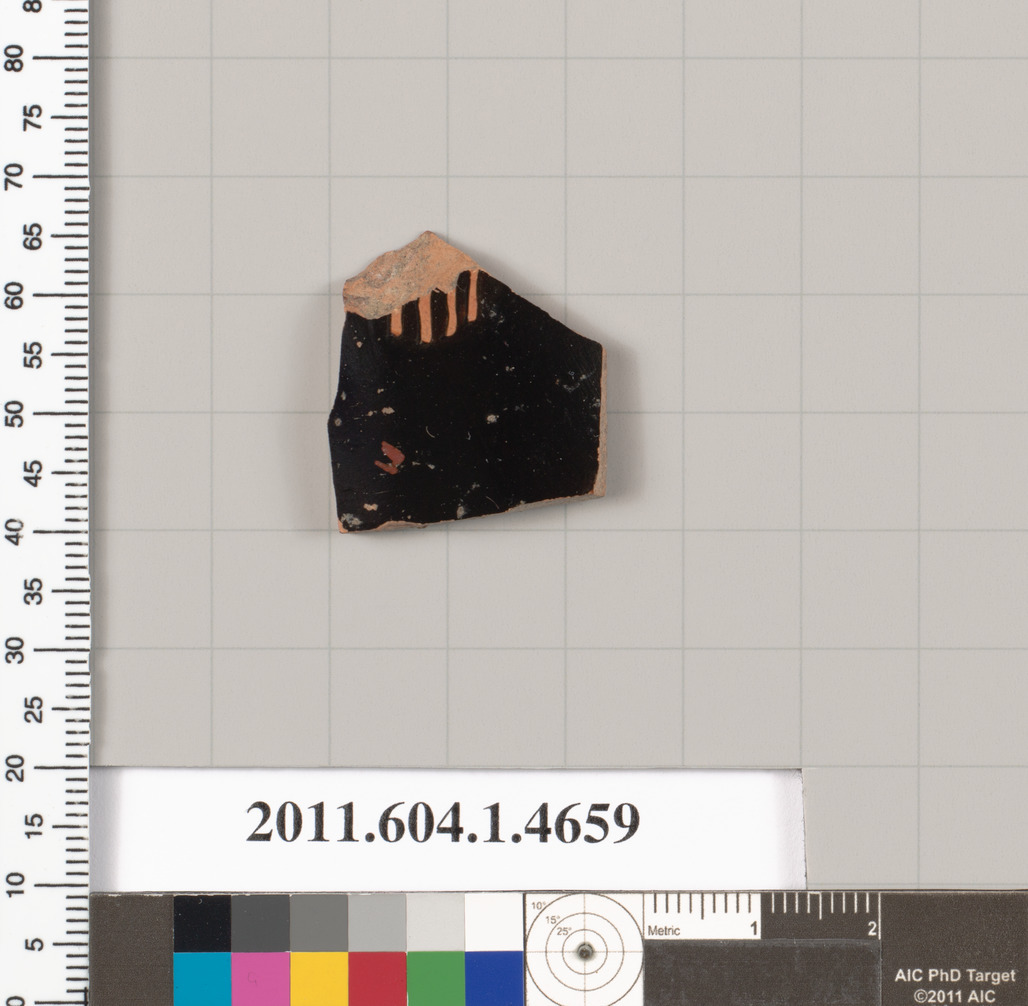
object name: kylix fragment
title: Terracotta fragment of a kylix (drinking cup)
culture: greek, attic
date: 520-500 BCE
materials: terracotta